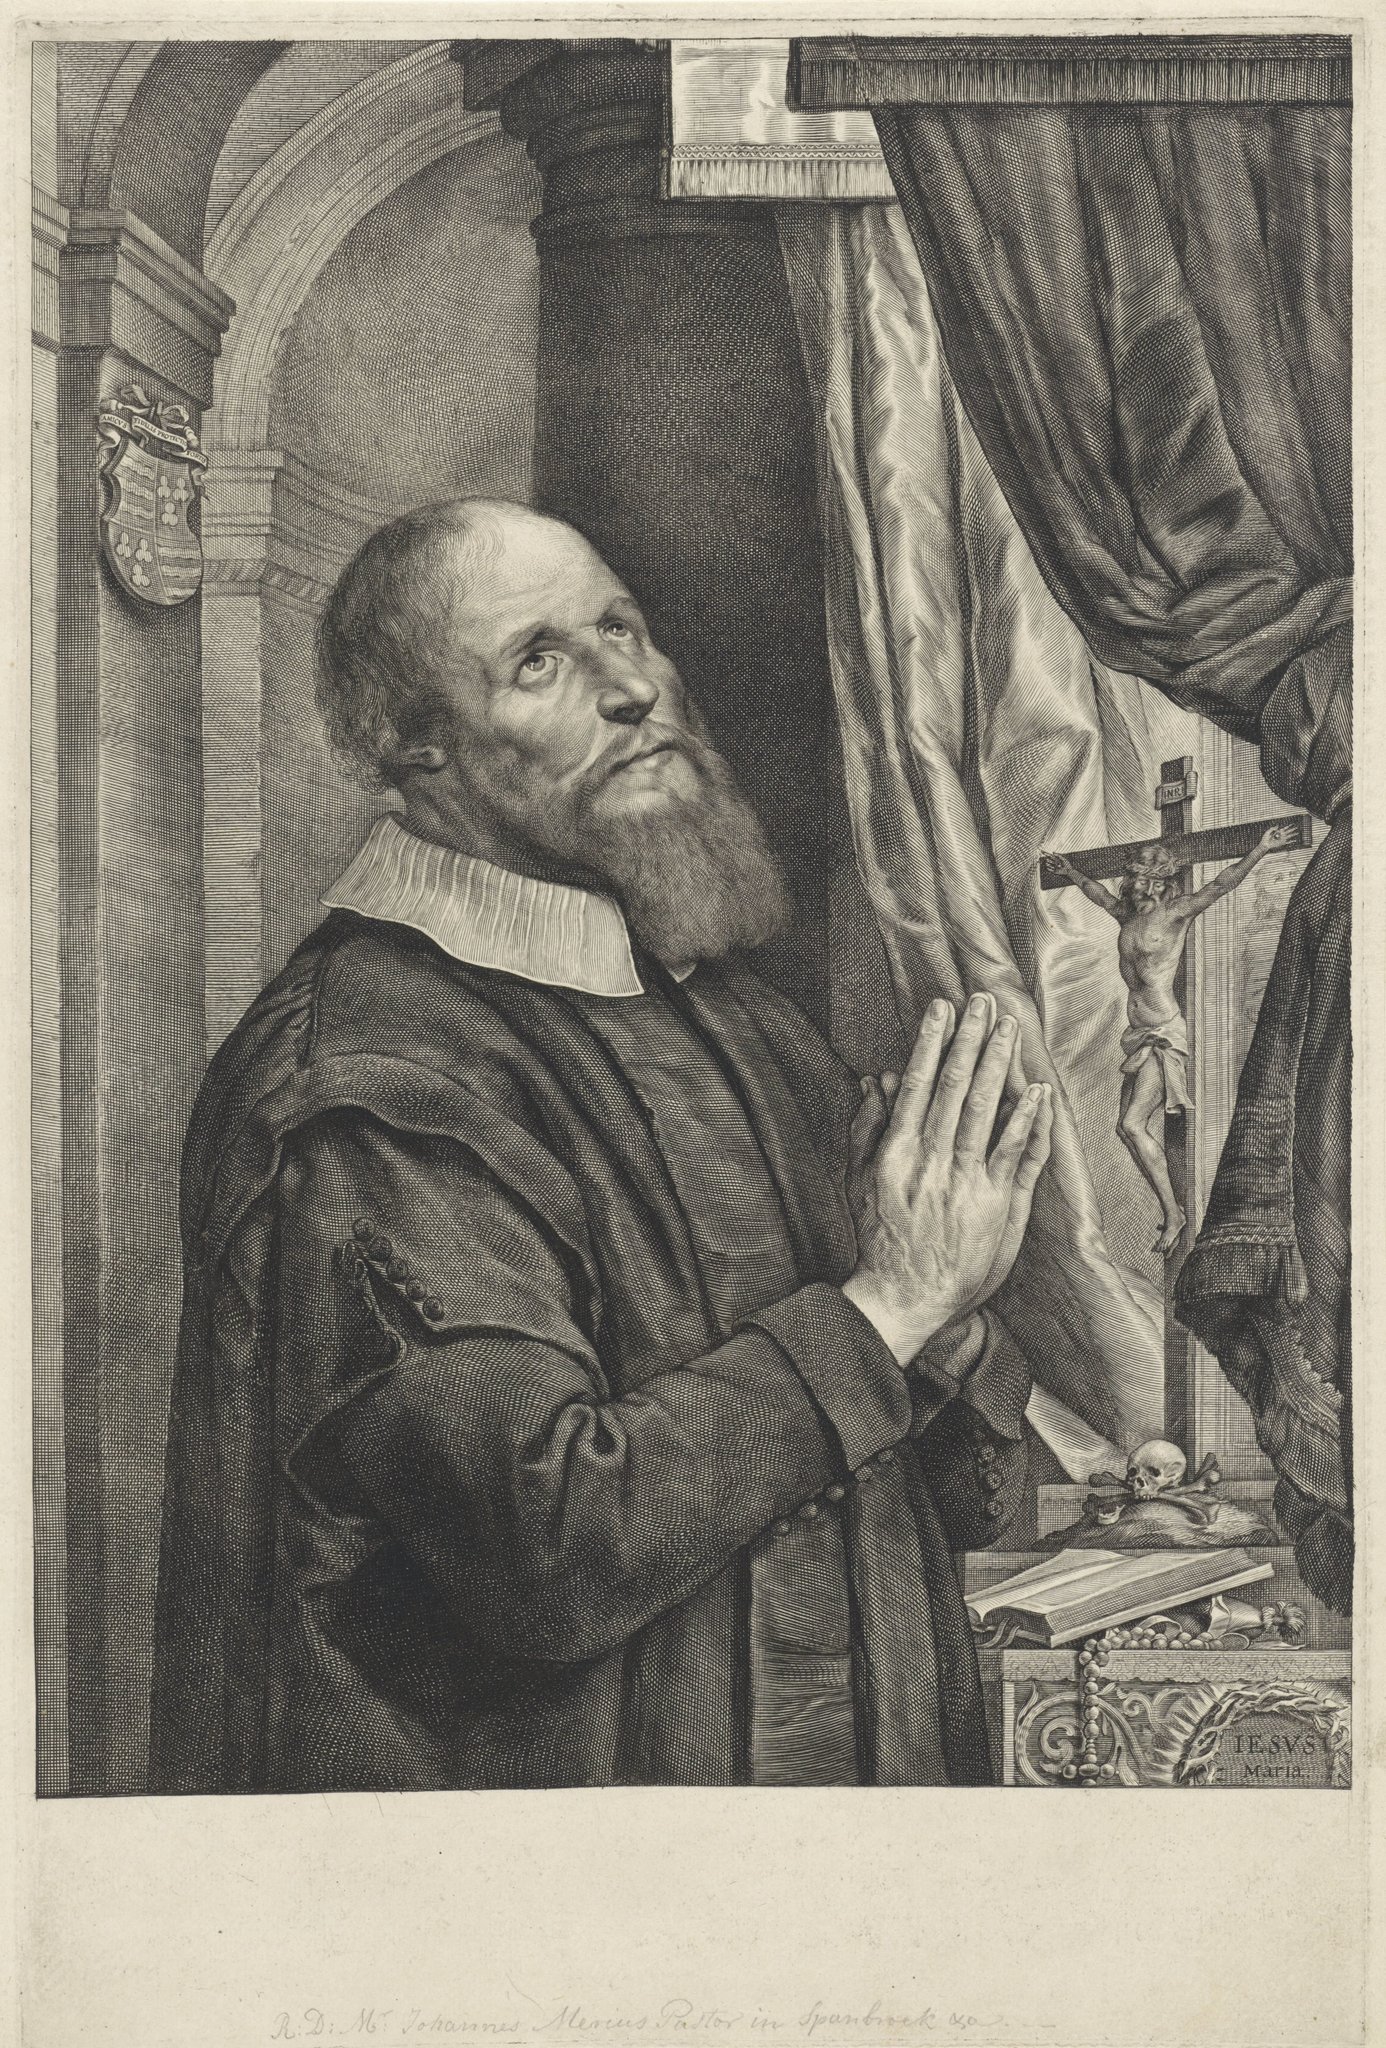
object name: print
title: Portret van Joannes van der Meer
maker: cornelis visscher (ii)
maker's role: draughtsman, painter, print maker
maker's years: 1628-1658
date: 1652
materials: paper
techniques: engraving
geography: haarlem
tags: aids for prayer, e.g. rosary, crucifix ~ personal devotion, one person praying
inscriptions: collector's mark: Lugt 240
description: Pastoor Joannes van der Meer met gevouwen handen bij een crucifix, een rozenkrans en een bijbel. Hij heeft zijn blik naar de hemel gericht. Deze prent is ter gelegenheid van zijn overlijden vervaardigd.